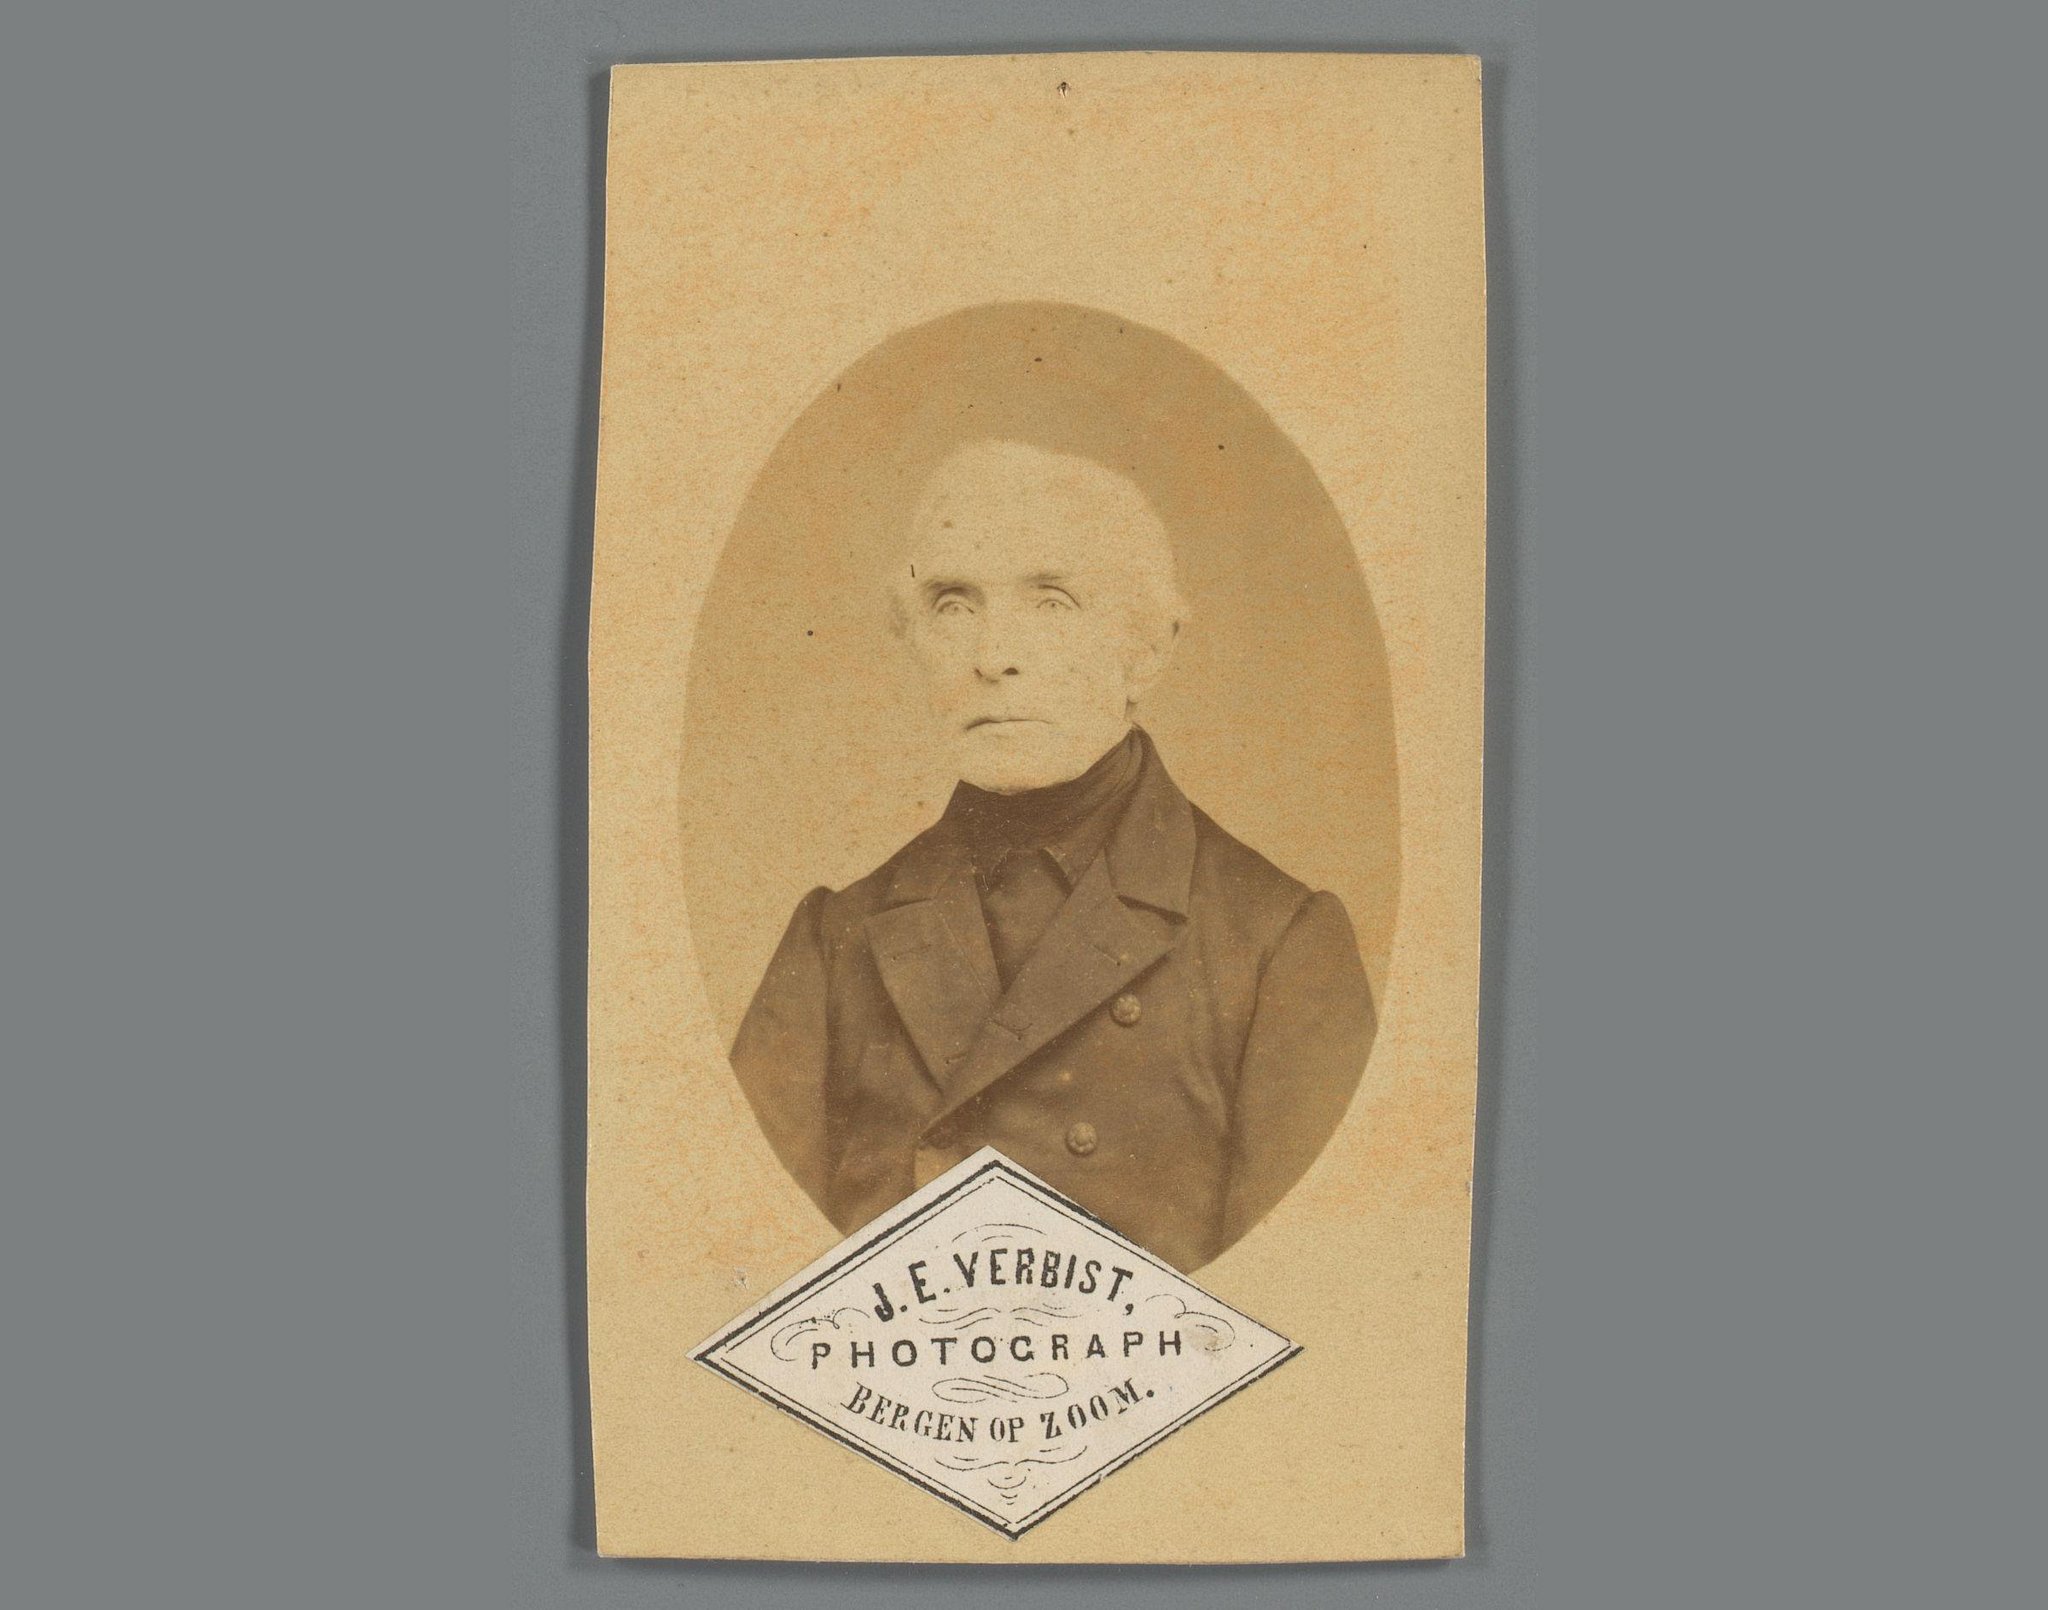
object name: semi enamel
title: Portret van Joseph Henricus Legge op bidprent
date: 1877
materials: cardboard, paper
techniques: albumen print, letterpress printing, lithograph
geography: bergen op zoom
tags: bergen op zoom, historical persons, old man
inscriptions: inscription: ‘J.E. Verbist,/ Photograph/ Bergen op Zoom.’, inscription: ‘Gedenk in uwe gebeden (...) R.I.P,/ Boekdr. J.J.H. Verlinden, Bergen-op-Zoom.’